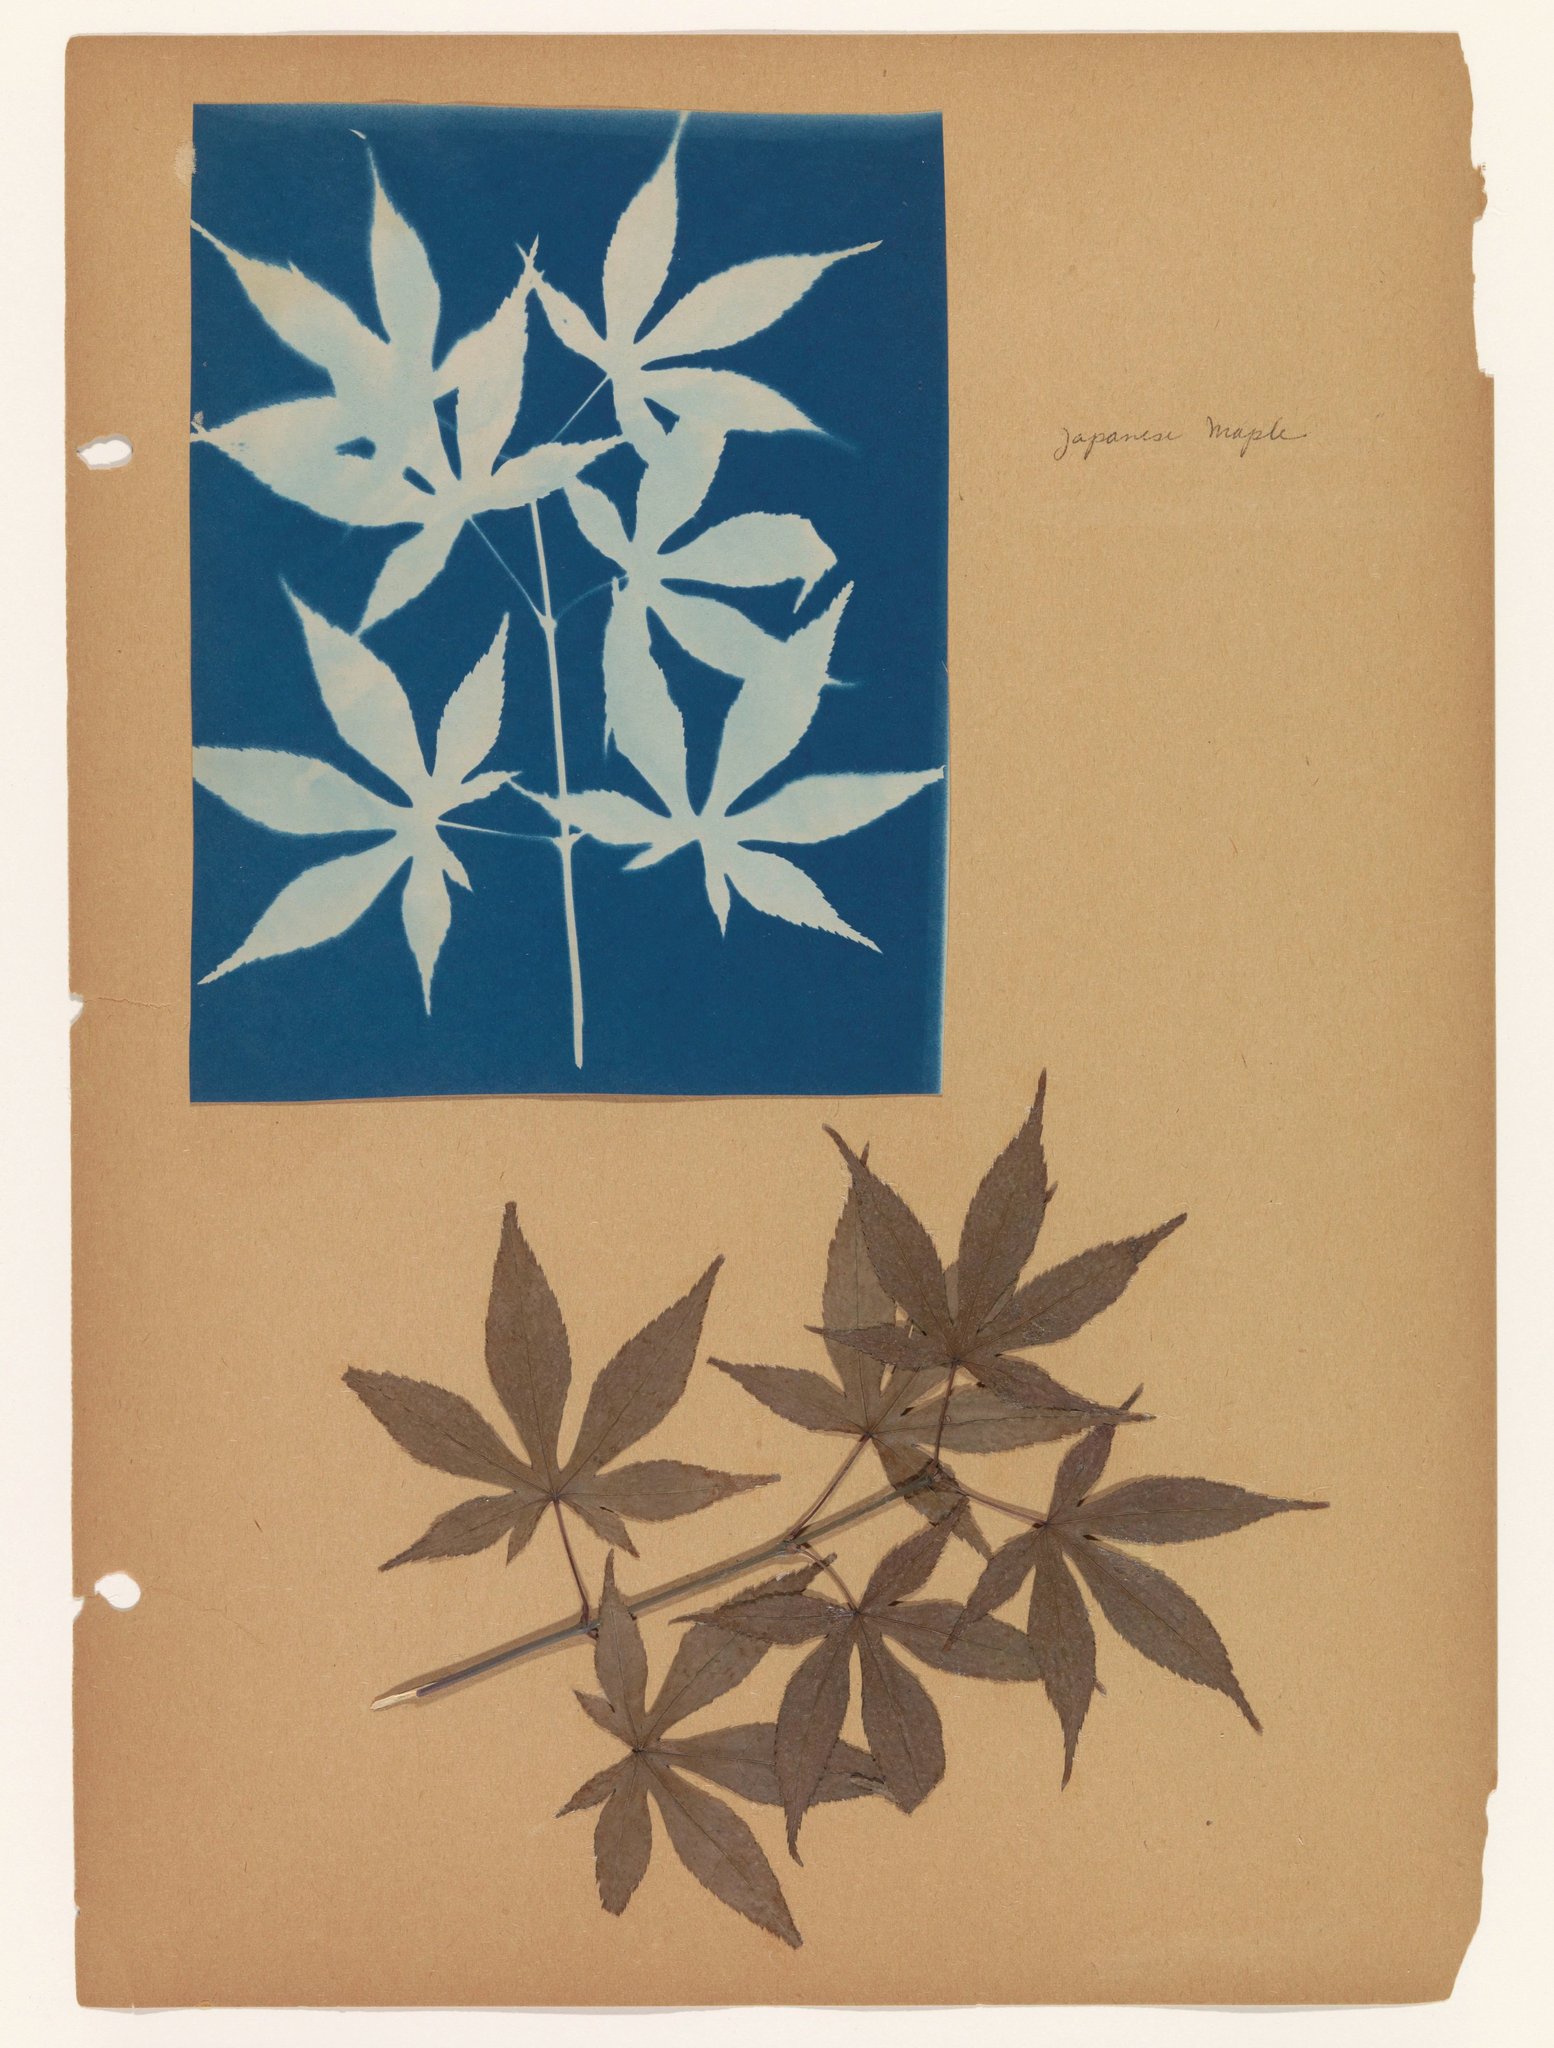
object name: photogram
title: Blad met cyanotypie fotogram van blad van een Japanse esdoorn en het blad zelf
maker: Anonymous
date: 1900-1920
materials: paper, photographic support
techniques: cyanotype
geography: united states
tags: trees (+ leaf)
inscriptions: annotation: ‘japanese maple’